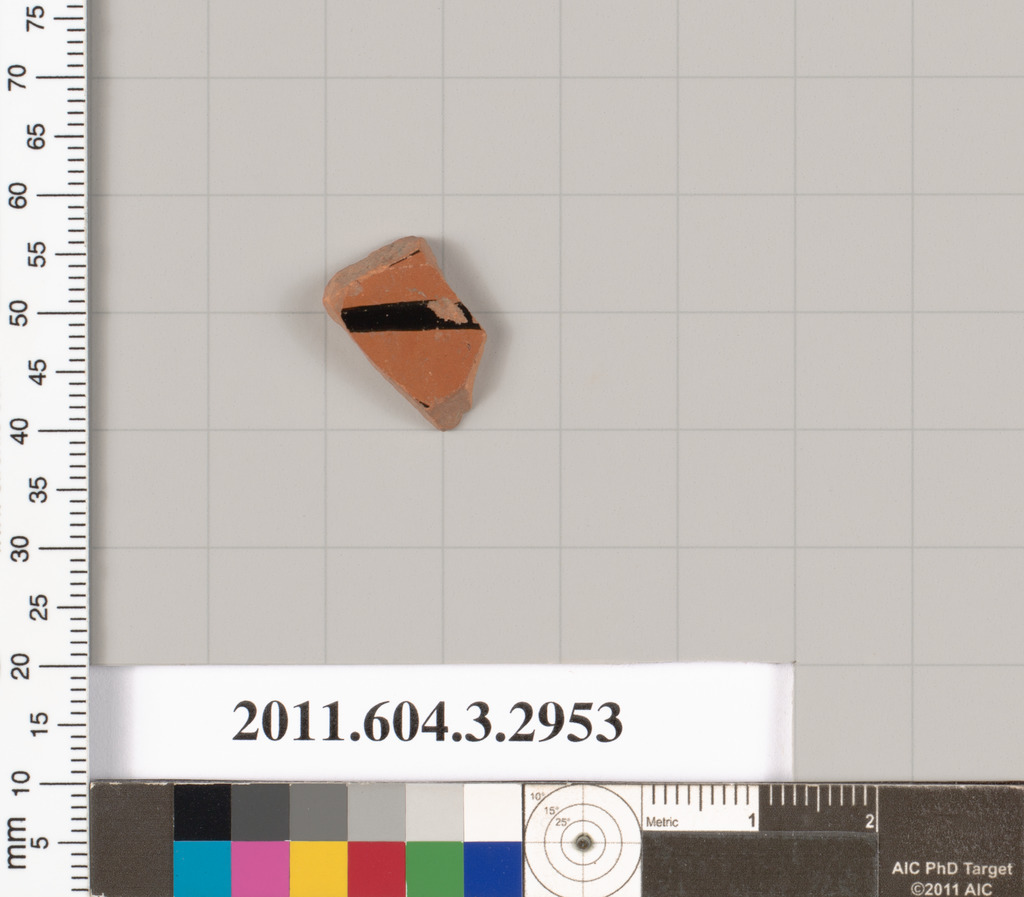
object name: undetermined shape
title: Terracotta fragment of an undetermined shape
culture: greek, attic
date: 600-401 BCE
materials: terracotta